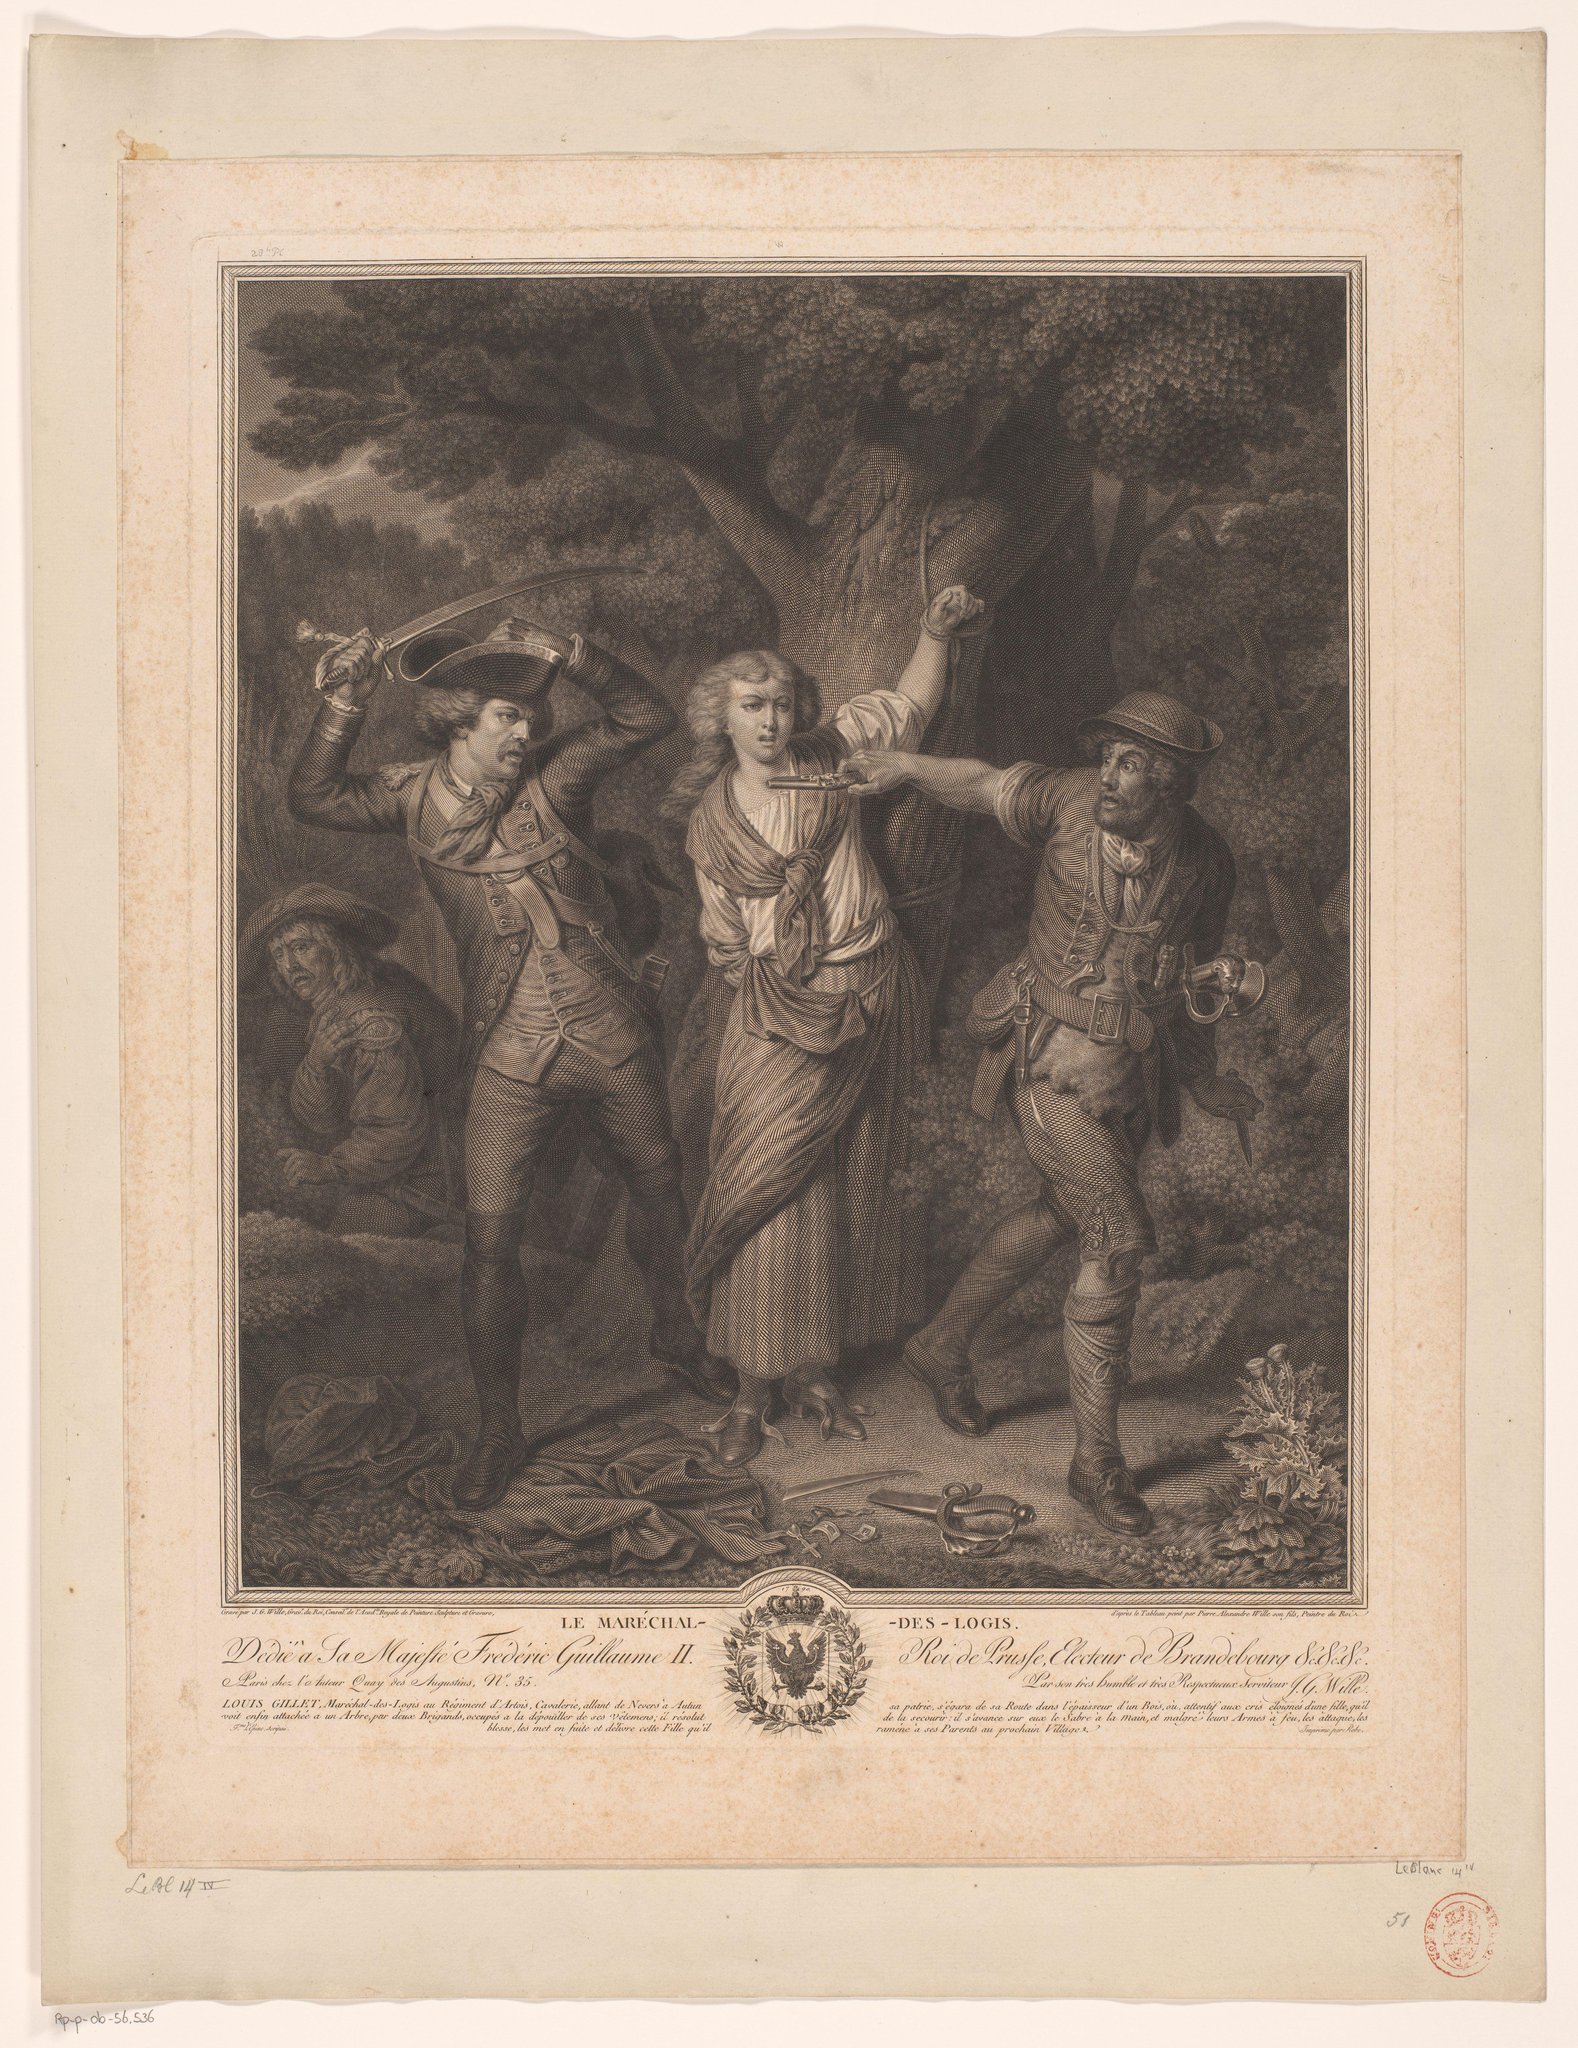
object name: print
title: Vastgebonden vrouw wordt door een maarschalk gered van haar ontvoerder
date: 1790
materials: paper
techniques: engraving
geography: paris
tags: commander-in-chief, general, marshal, kidnapping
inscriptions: collector's mark: Lugt 240